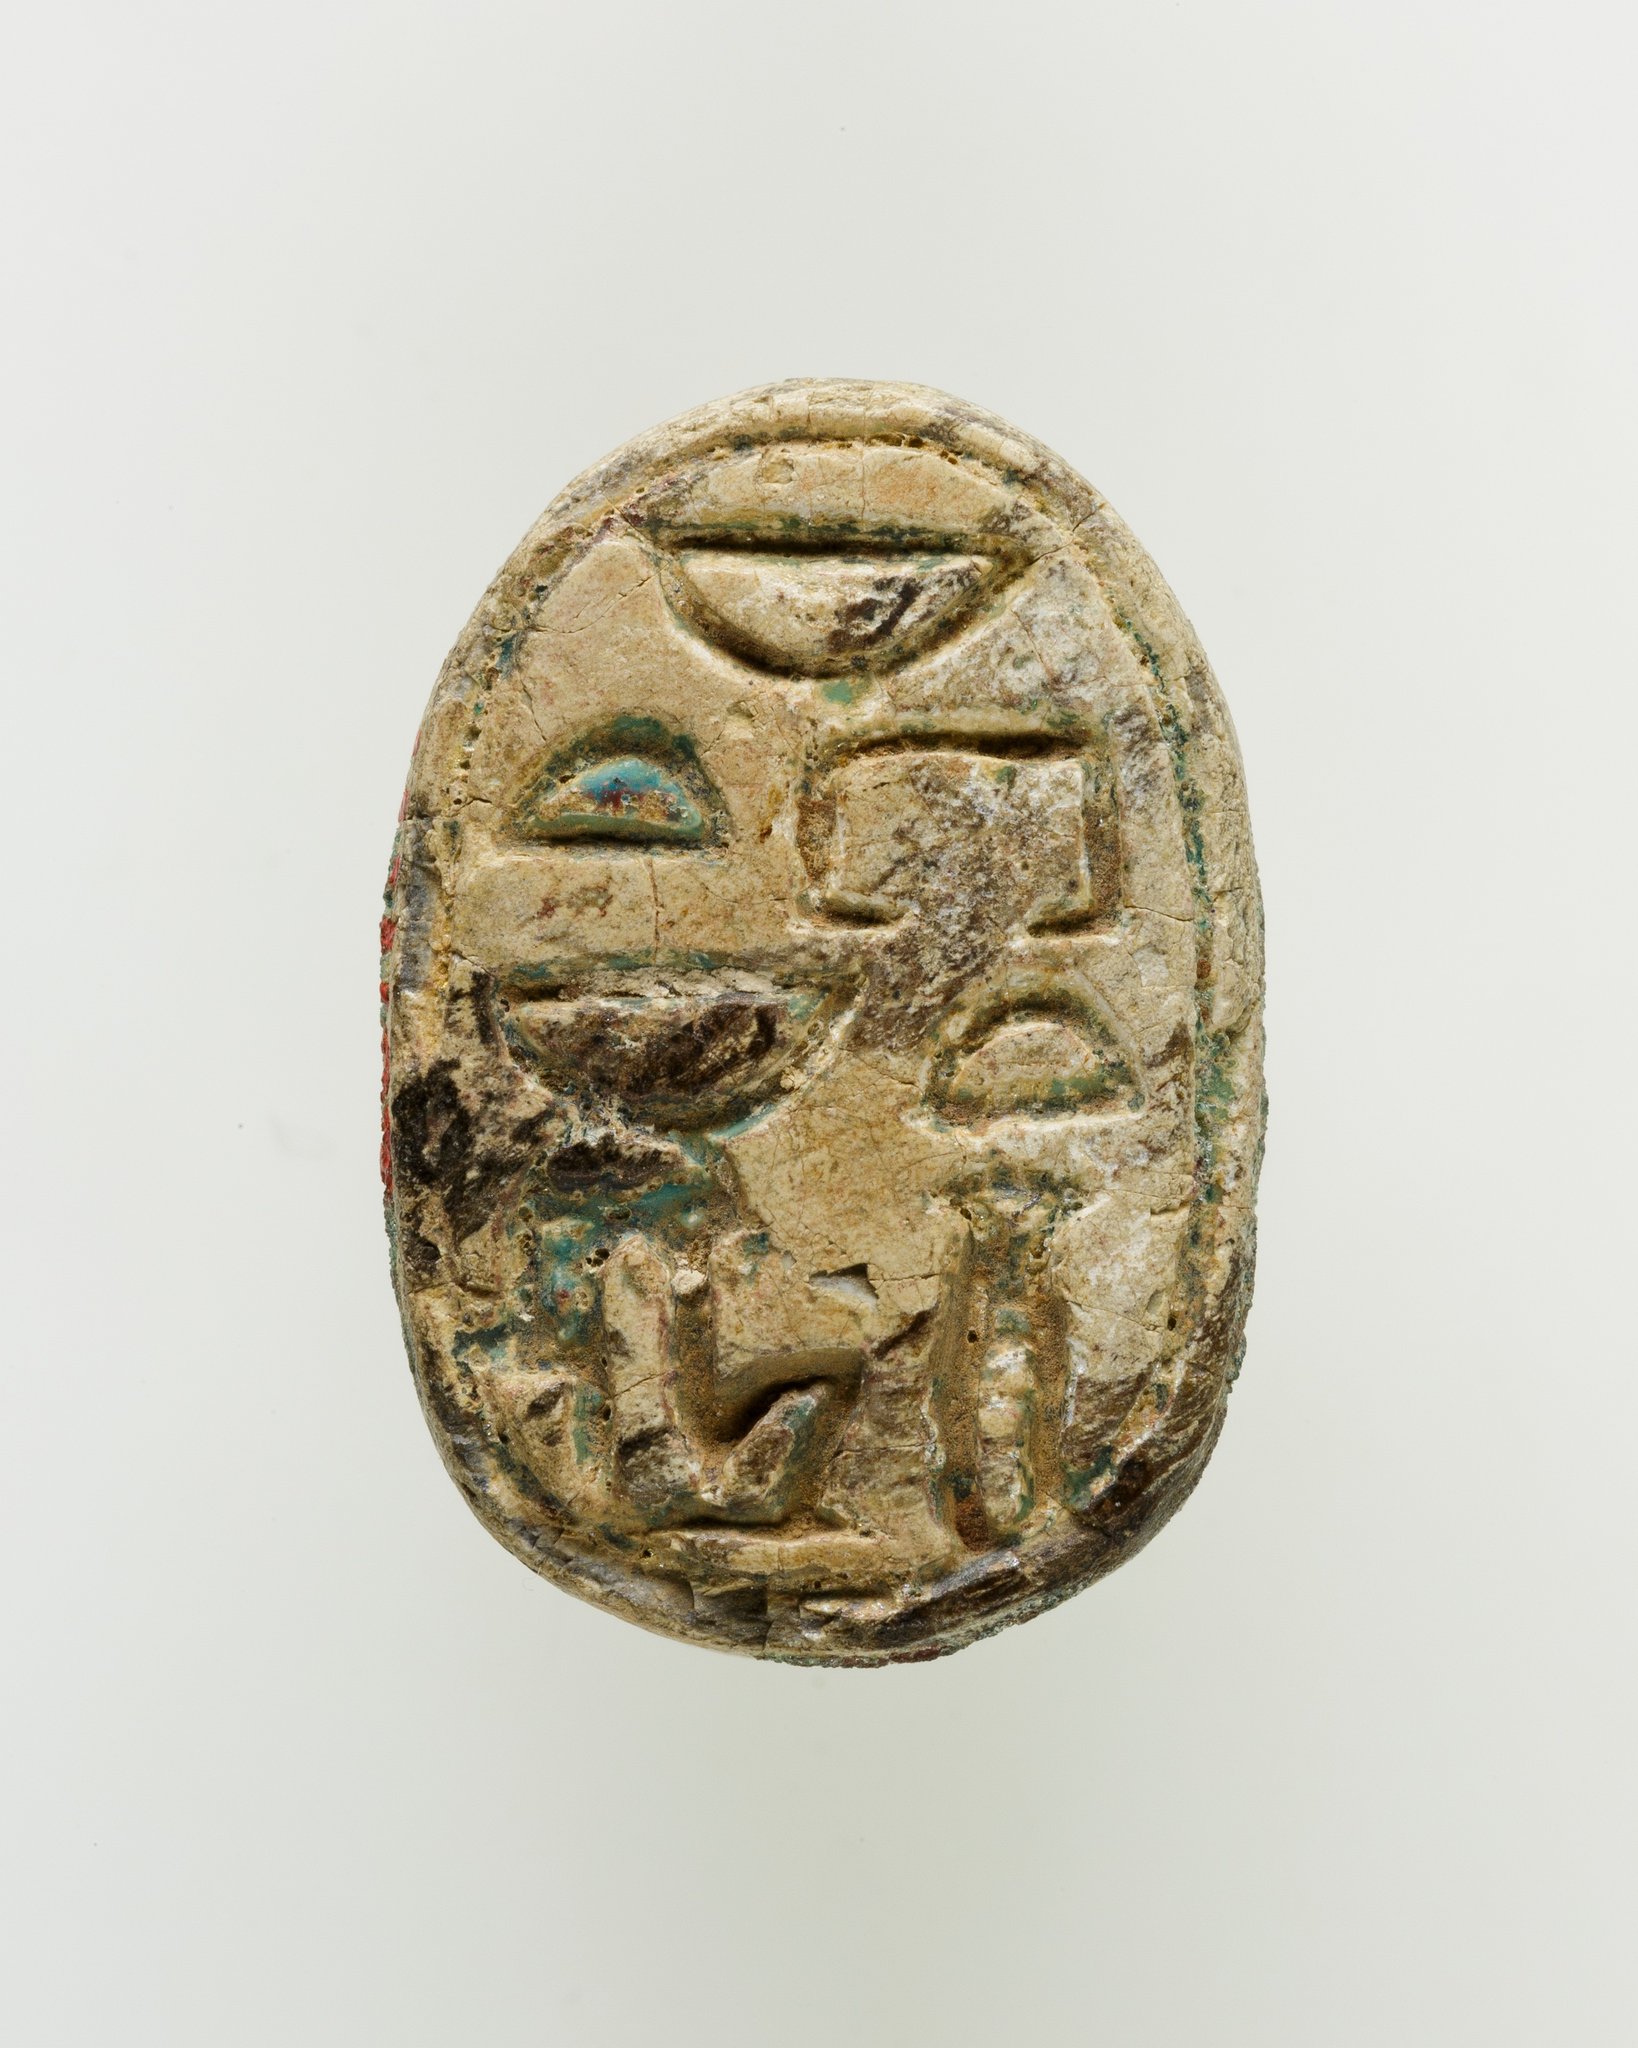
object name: scarab, lady of the house nebetwadjyt, private name and title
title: Scarab of the Lady Nebetwadjyt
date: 1760-1670 BCE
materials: stone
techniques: glazing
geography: egypt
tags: scarabs